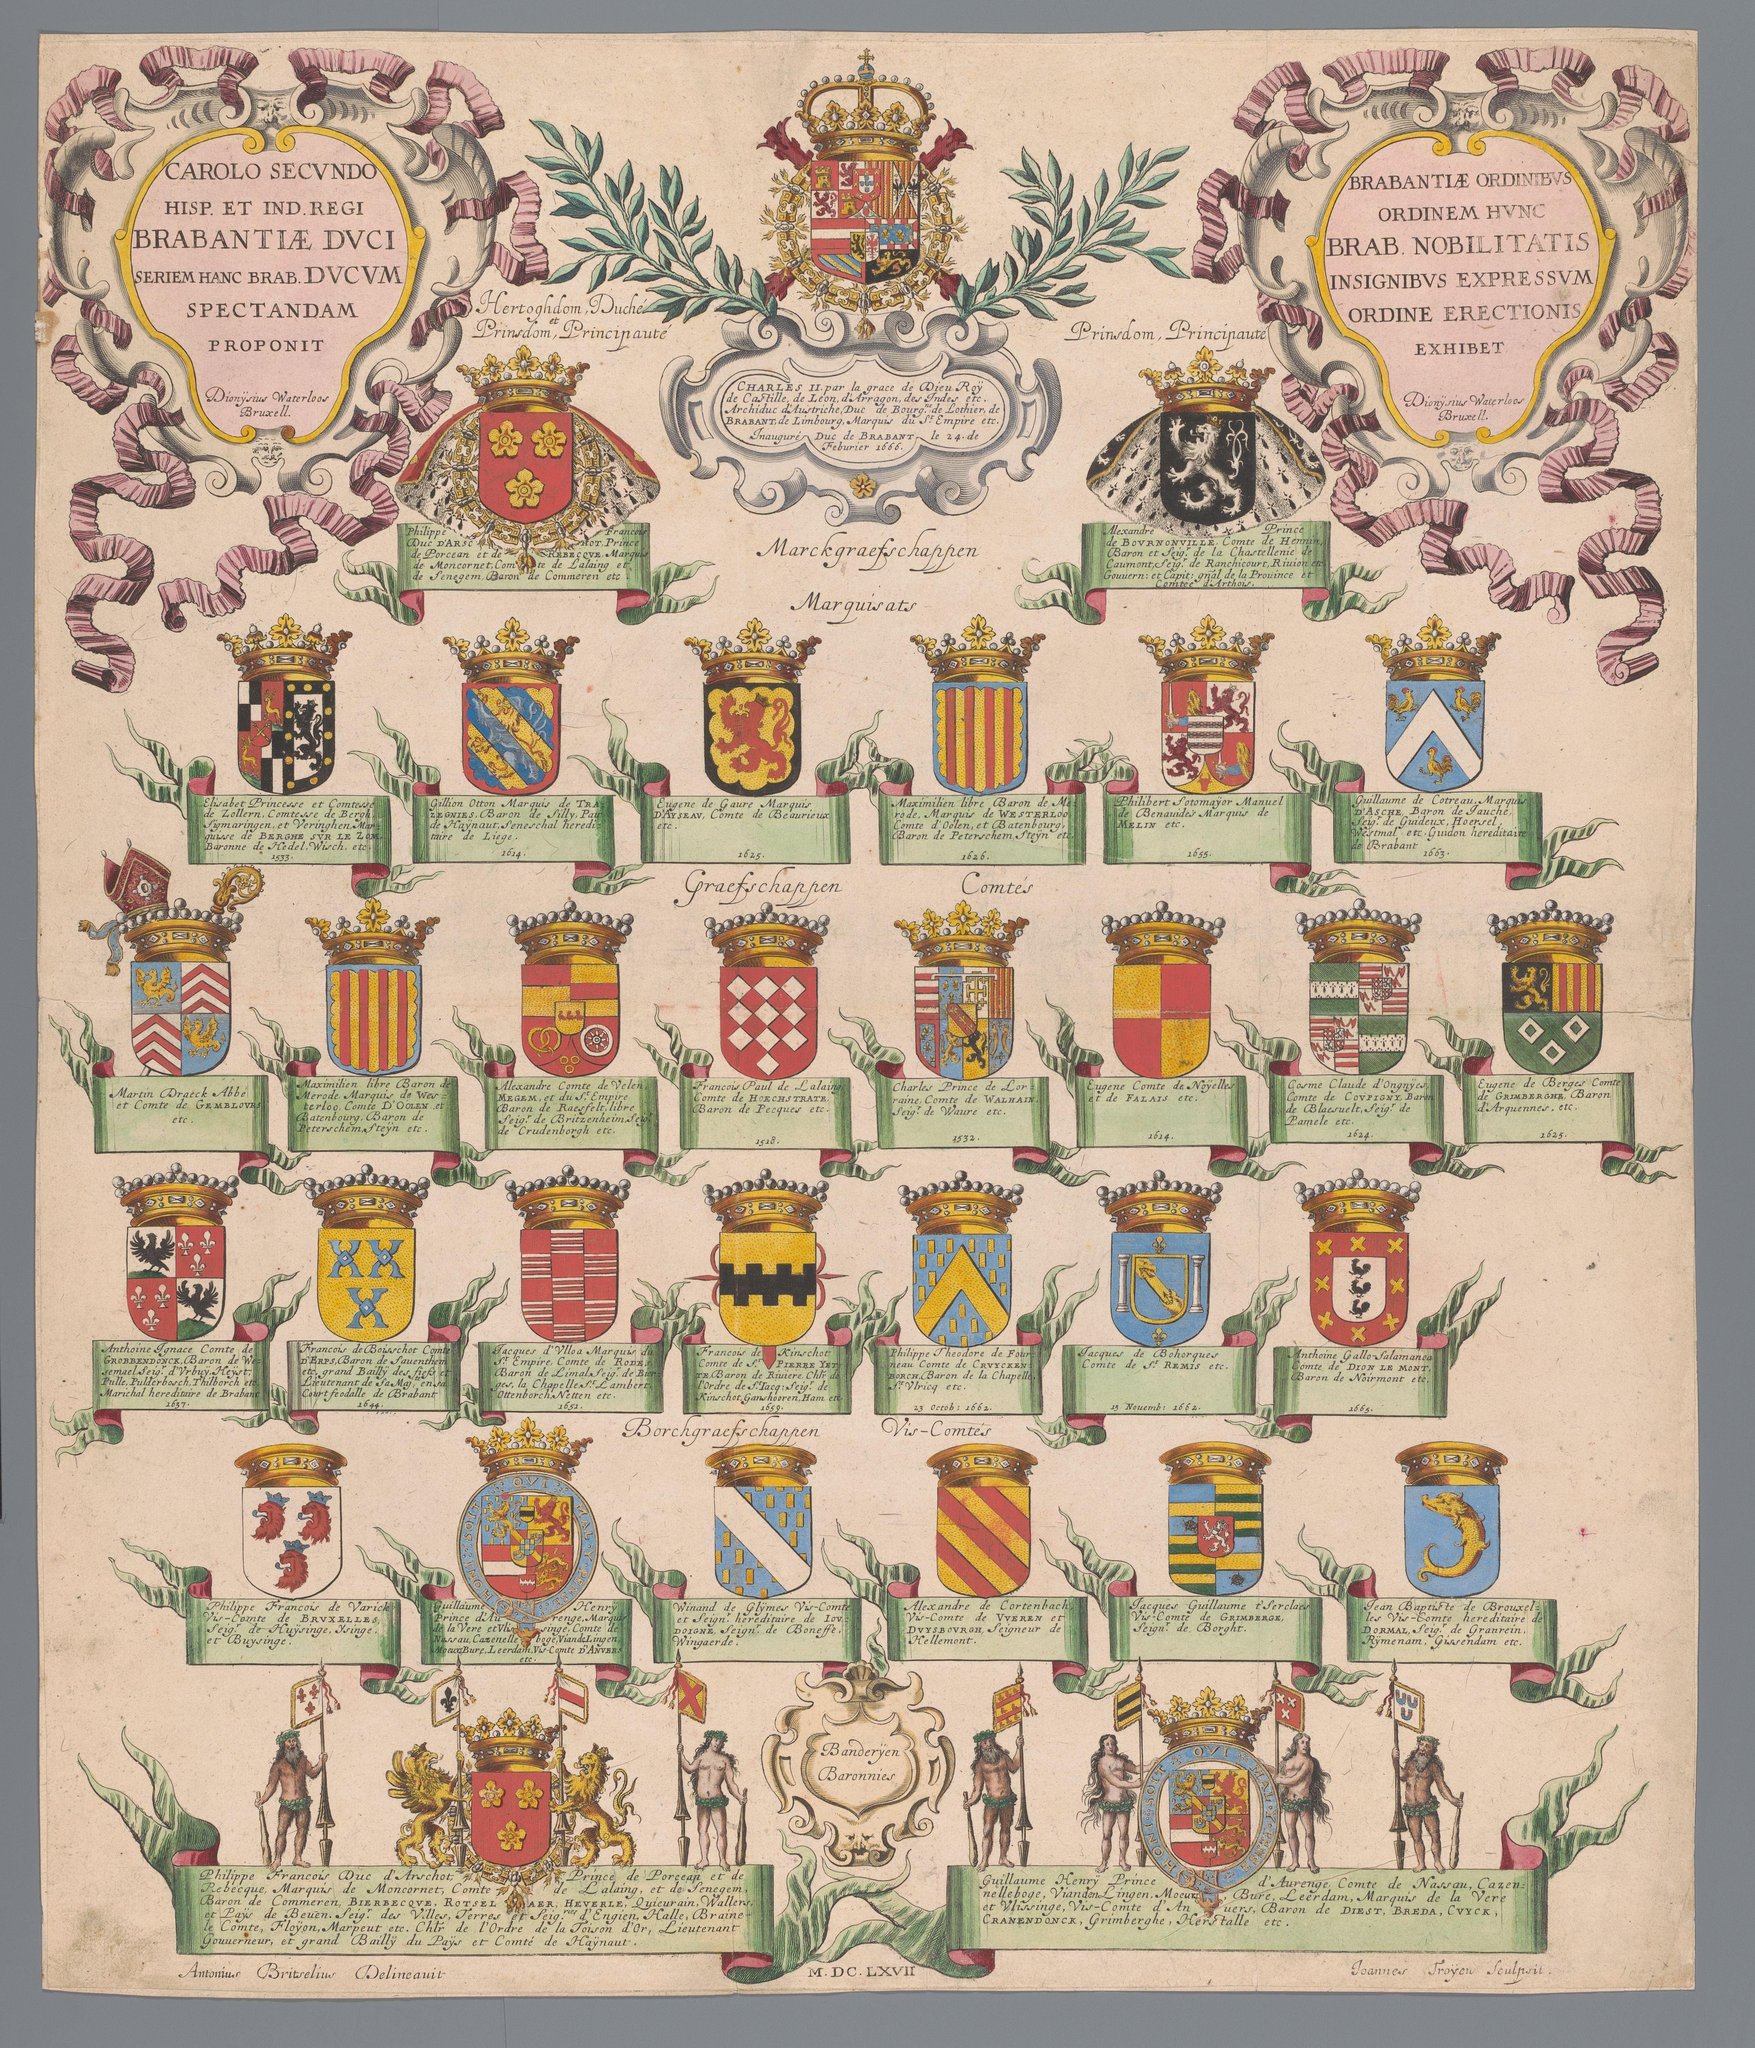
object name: print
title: Carlo Secundo Hisp et Ind. Regi Brabantiae Duci seriem hanc Brab. Ducum Spectandam Proponit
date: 1667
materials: paper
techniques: engraving, etching, hand coloring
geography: brussels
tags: karel ii (koning van spanje), coat of arms (as symbol of the state, etc.), brabant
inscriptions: date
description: Overzicht van de wapens van het hertogdom Brabant. Ter gelegenheid van de inauguratie van de Spaanse koning Karel II als hertog van Brabant, 24 februari 1666.